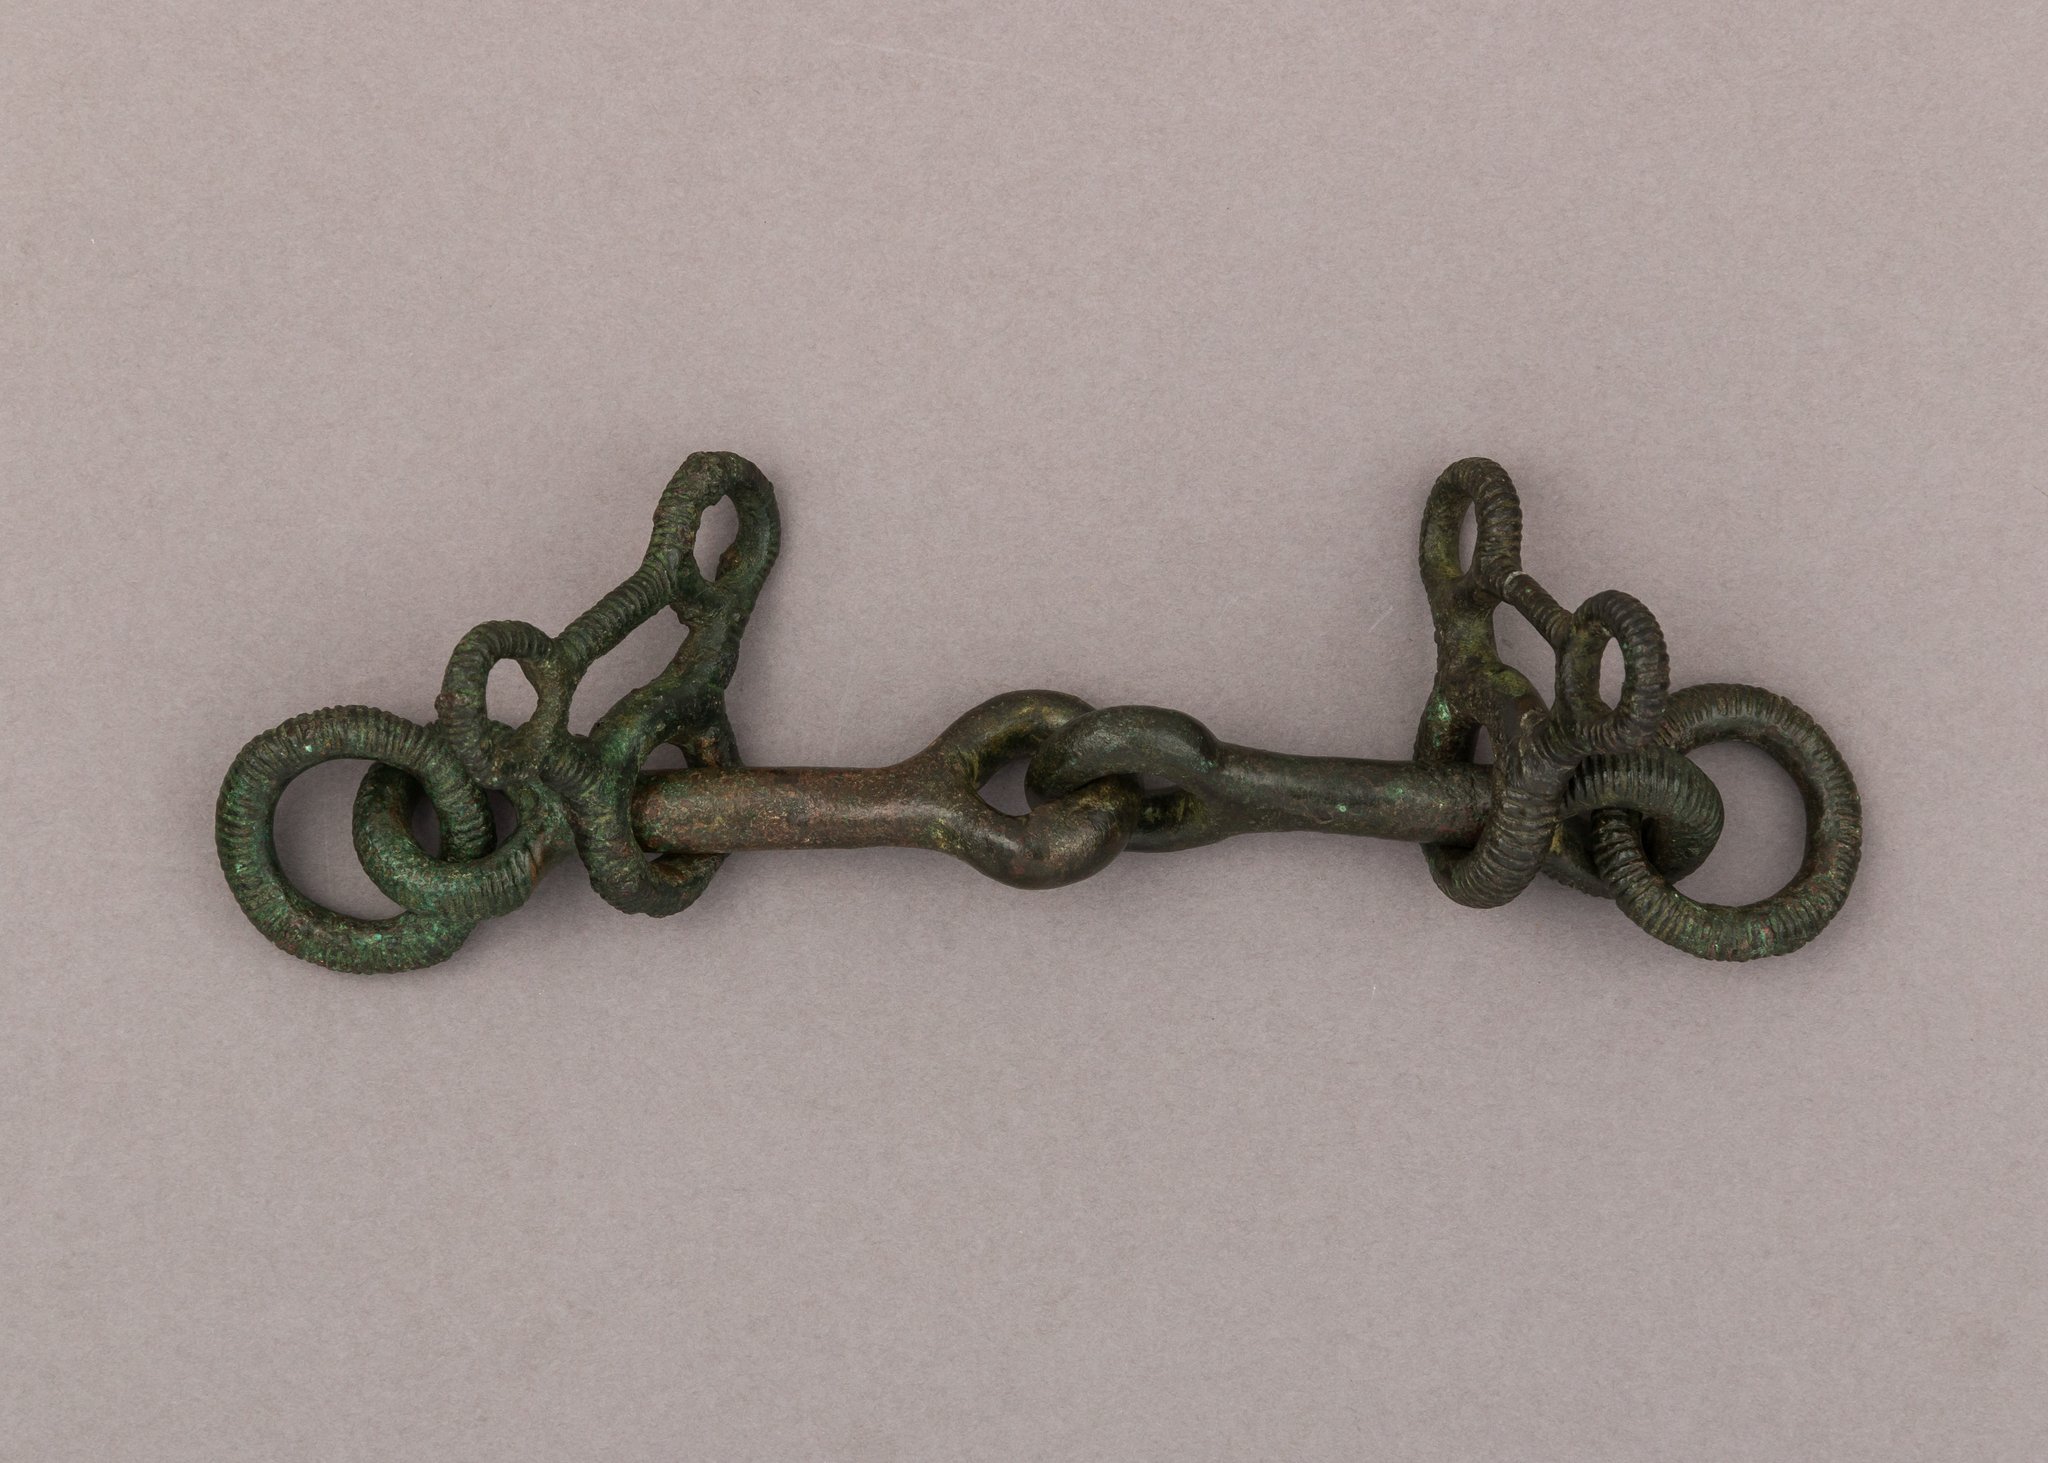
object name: bit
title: Snaffle Bit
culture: etruscan or villanovan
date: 800-601 BCE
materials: copper alloy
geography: italy